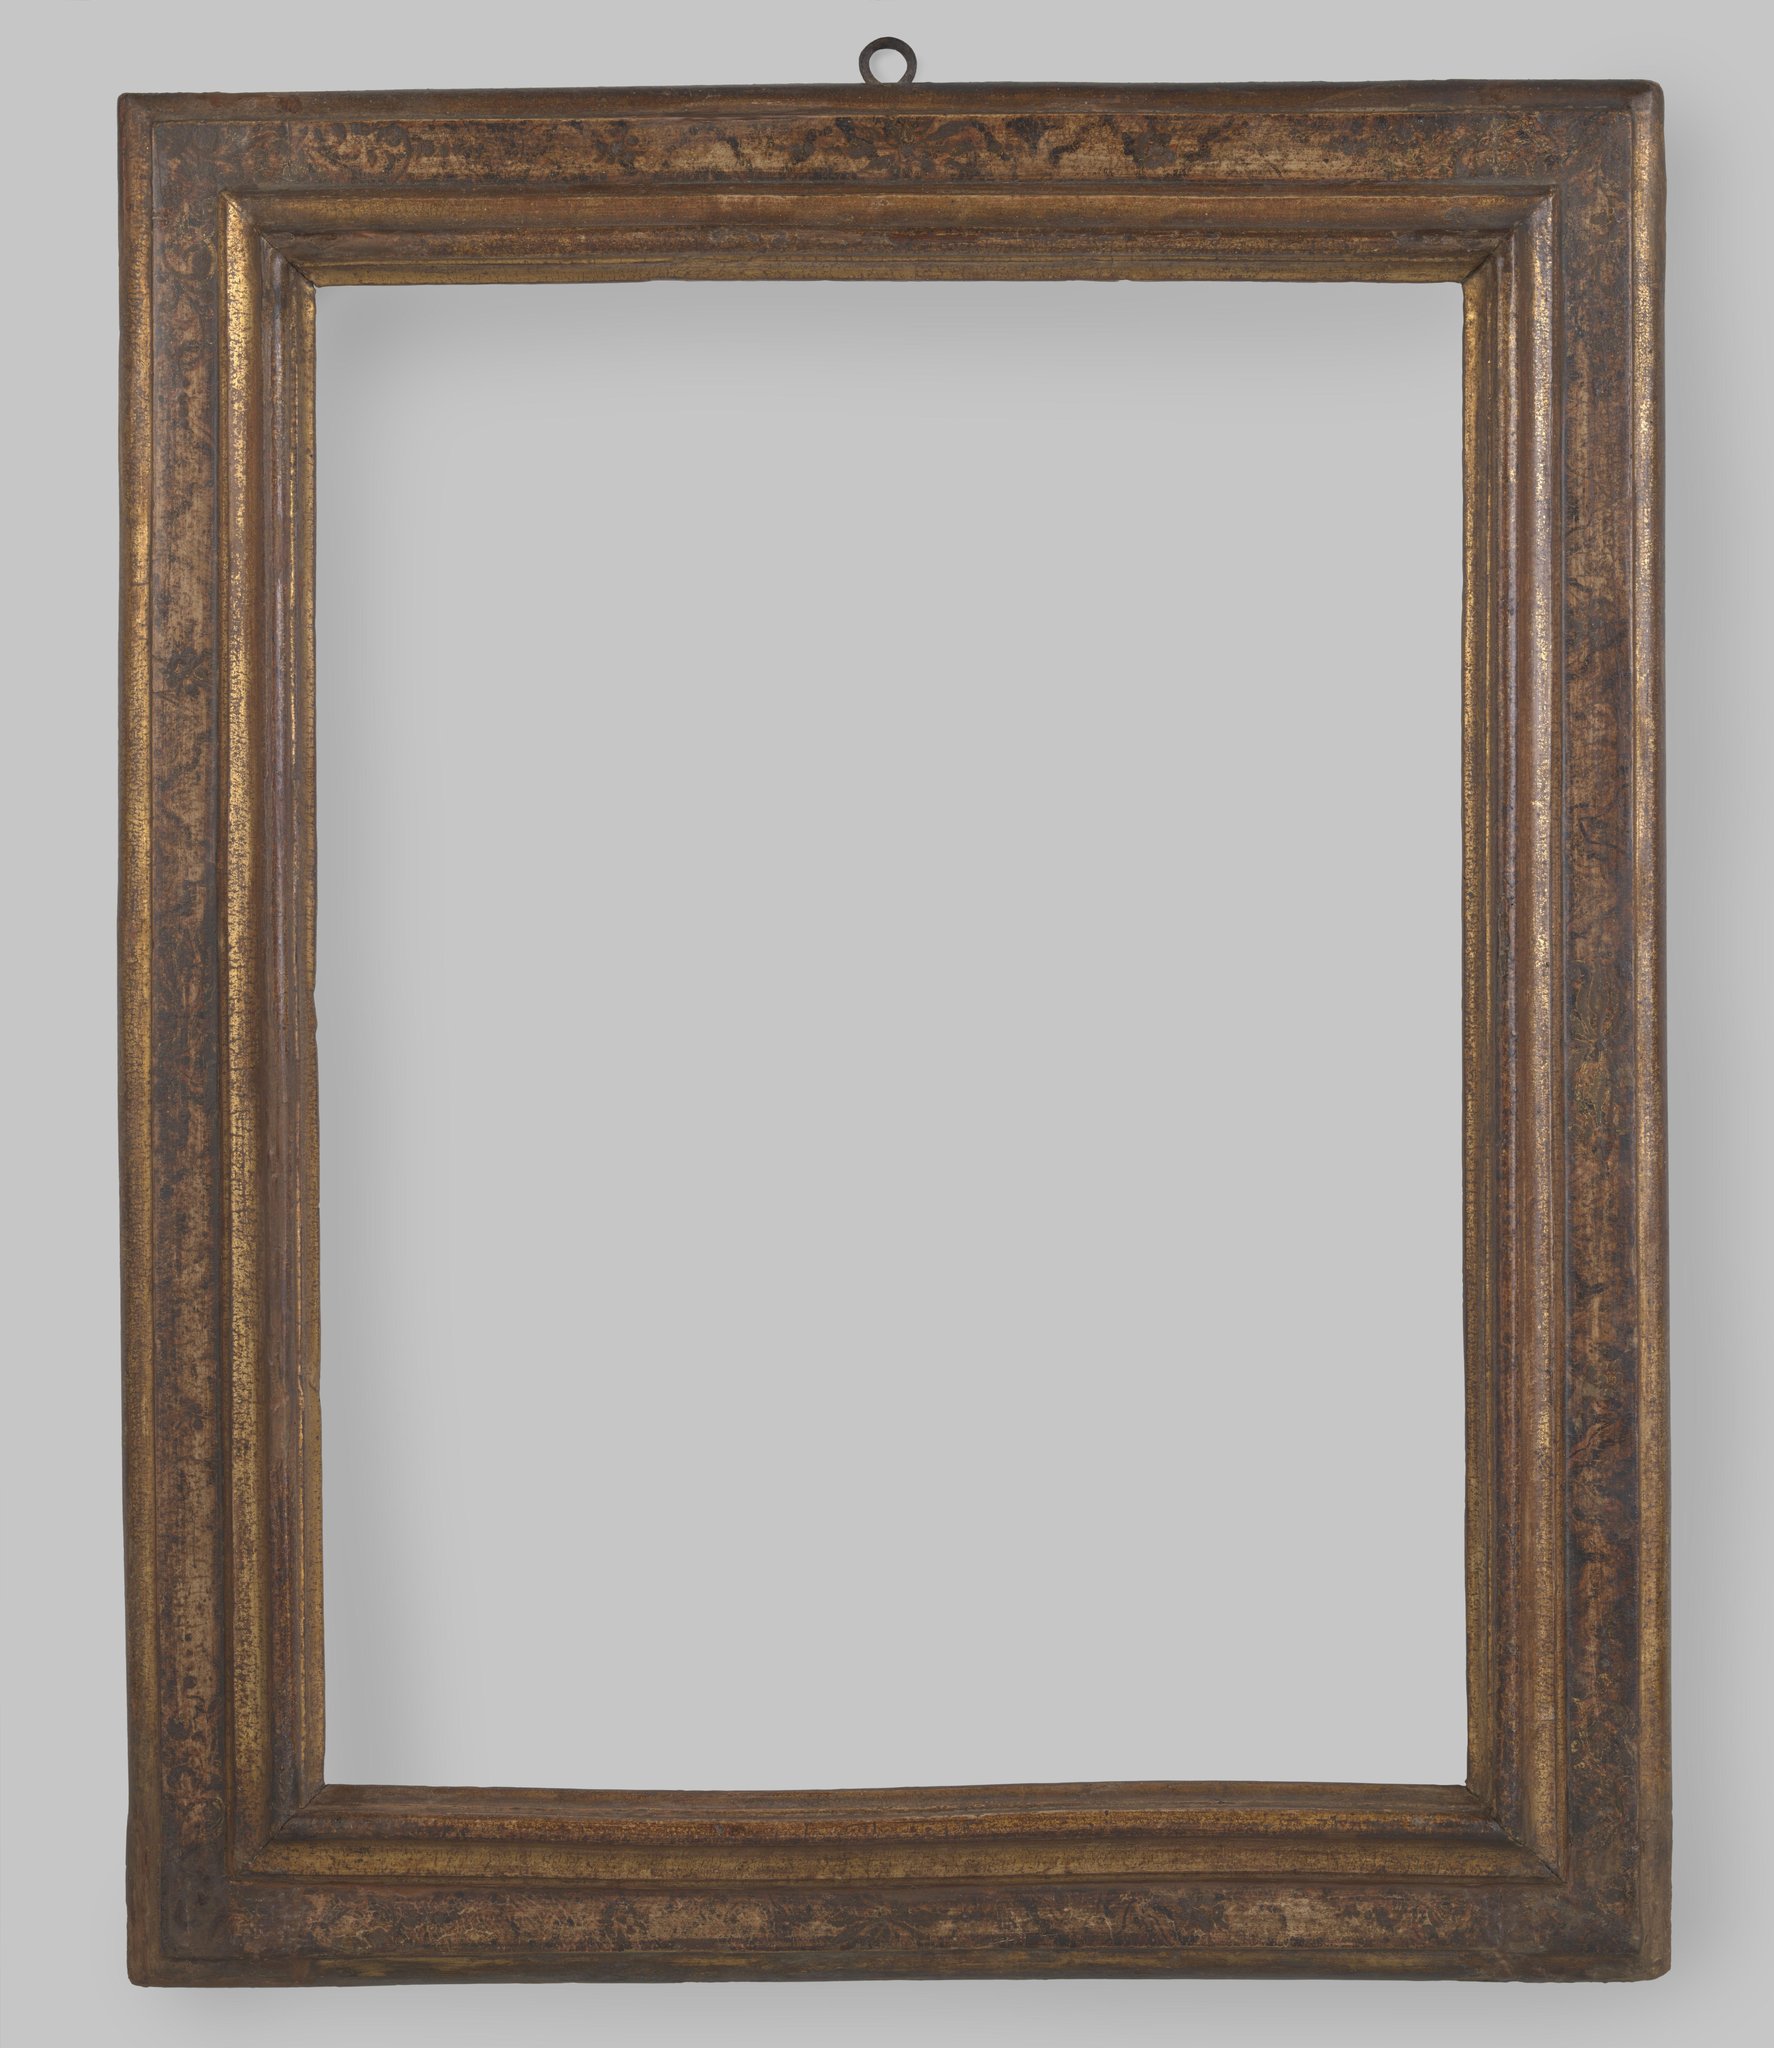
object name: frame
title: Gemarmerde renversé schilderijlijst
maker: Anonymous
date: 1650-1700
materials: gold leaf, paint, wood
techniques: gilding, planed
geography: italy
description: Vergulde en gemarmerde schilderijlijst met een renversé profiel. De brede vlakke middenstrook verspringt aan de buitenzijde naar een lager gelegen afgeronde buitenrand en wordt aan de dagkant begrensd door een samengesteld oplopend profiel. Beginnend met een richel en gevolgd door een ojief, vormt een kraal het hoogste deel van dit profiel, dat aan de dagkant wordt afgesloten door een lager gelegen vlakke trede. De vlakke bodem is beschilderd met marmerimitaties.